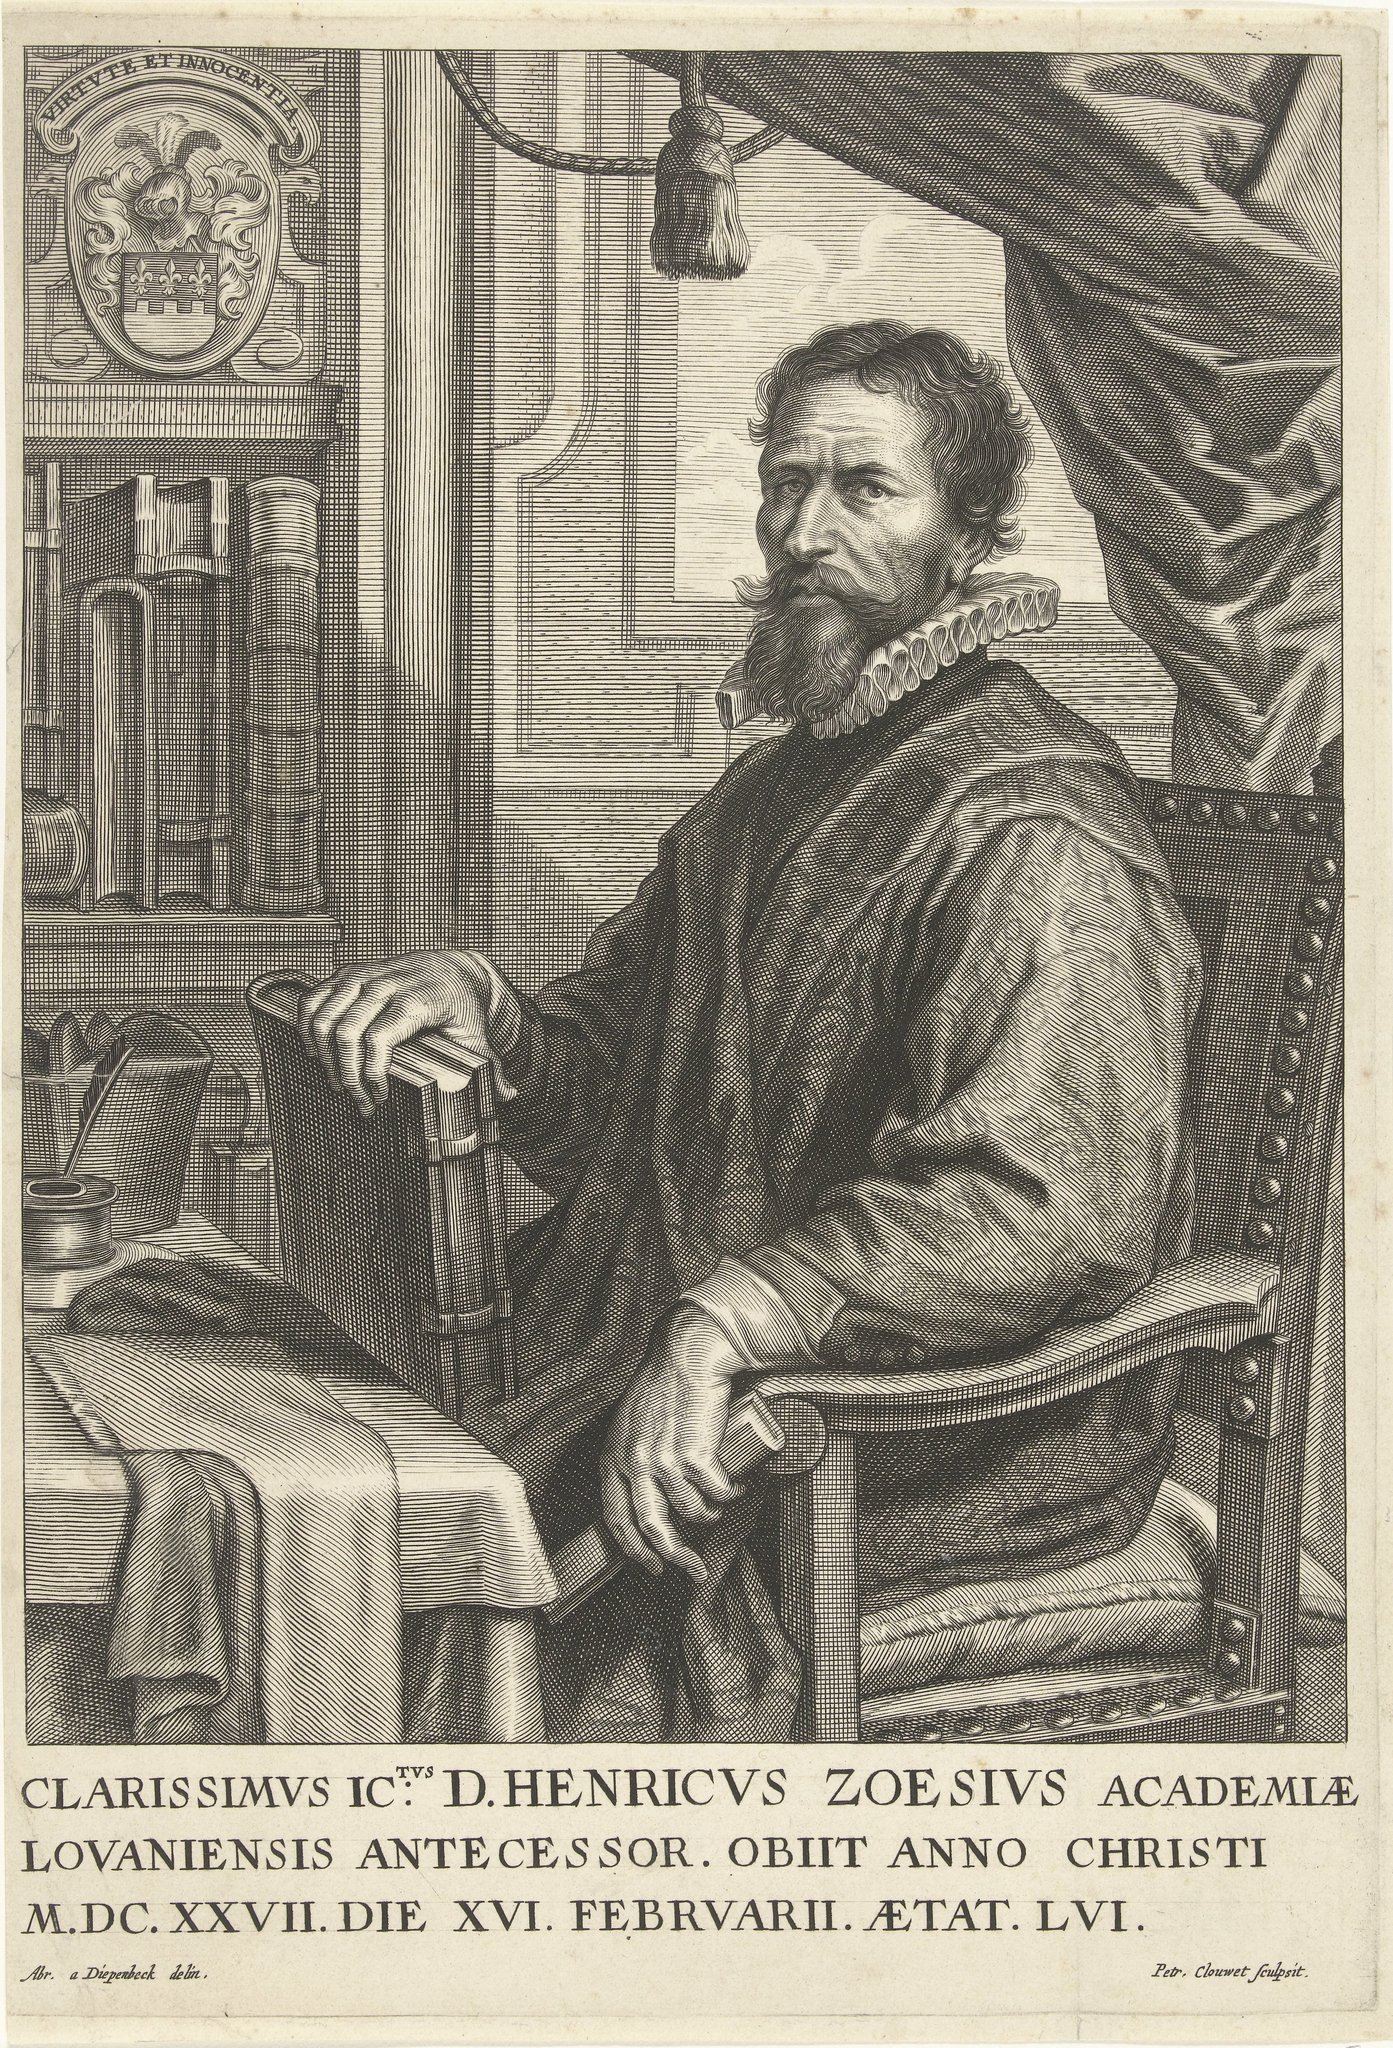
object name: print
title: Portret van Hendrik Zoesius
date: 1639-1670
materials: paper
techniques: engraving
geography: antwerp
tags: louvain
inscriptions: collector's mark: Lugt 2228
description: Portret van Hendrik Zoesius, hoogleraar Grieks en Rechtsgeleerdheid aan de universiteit van Leuven. Zoesius zit voor zijn bureau en heeft een boek in de rechterhand. De prent heeft een Latijns onderschrift.